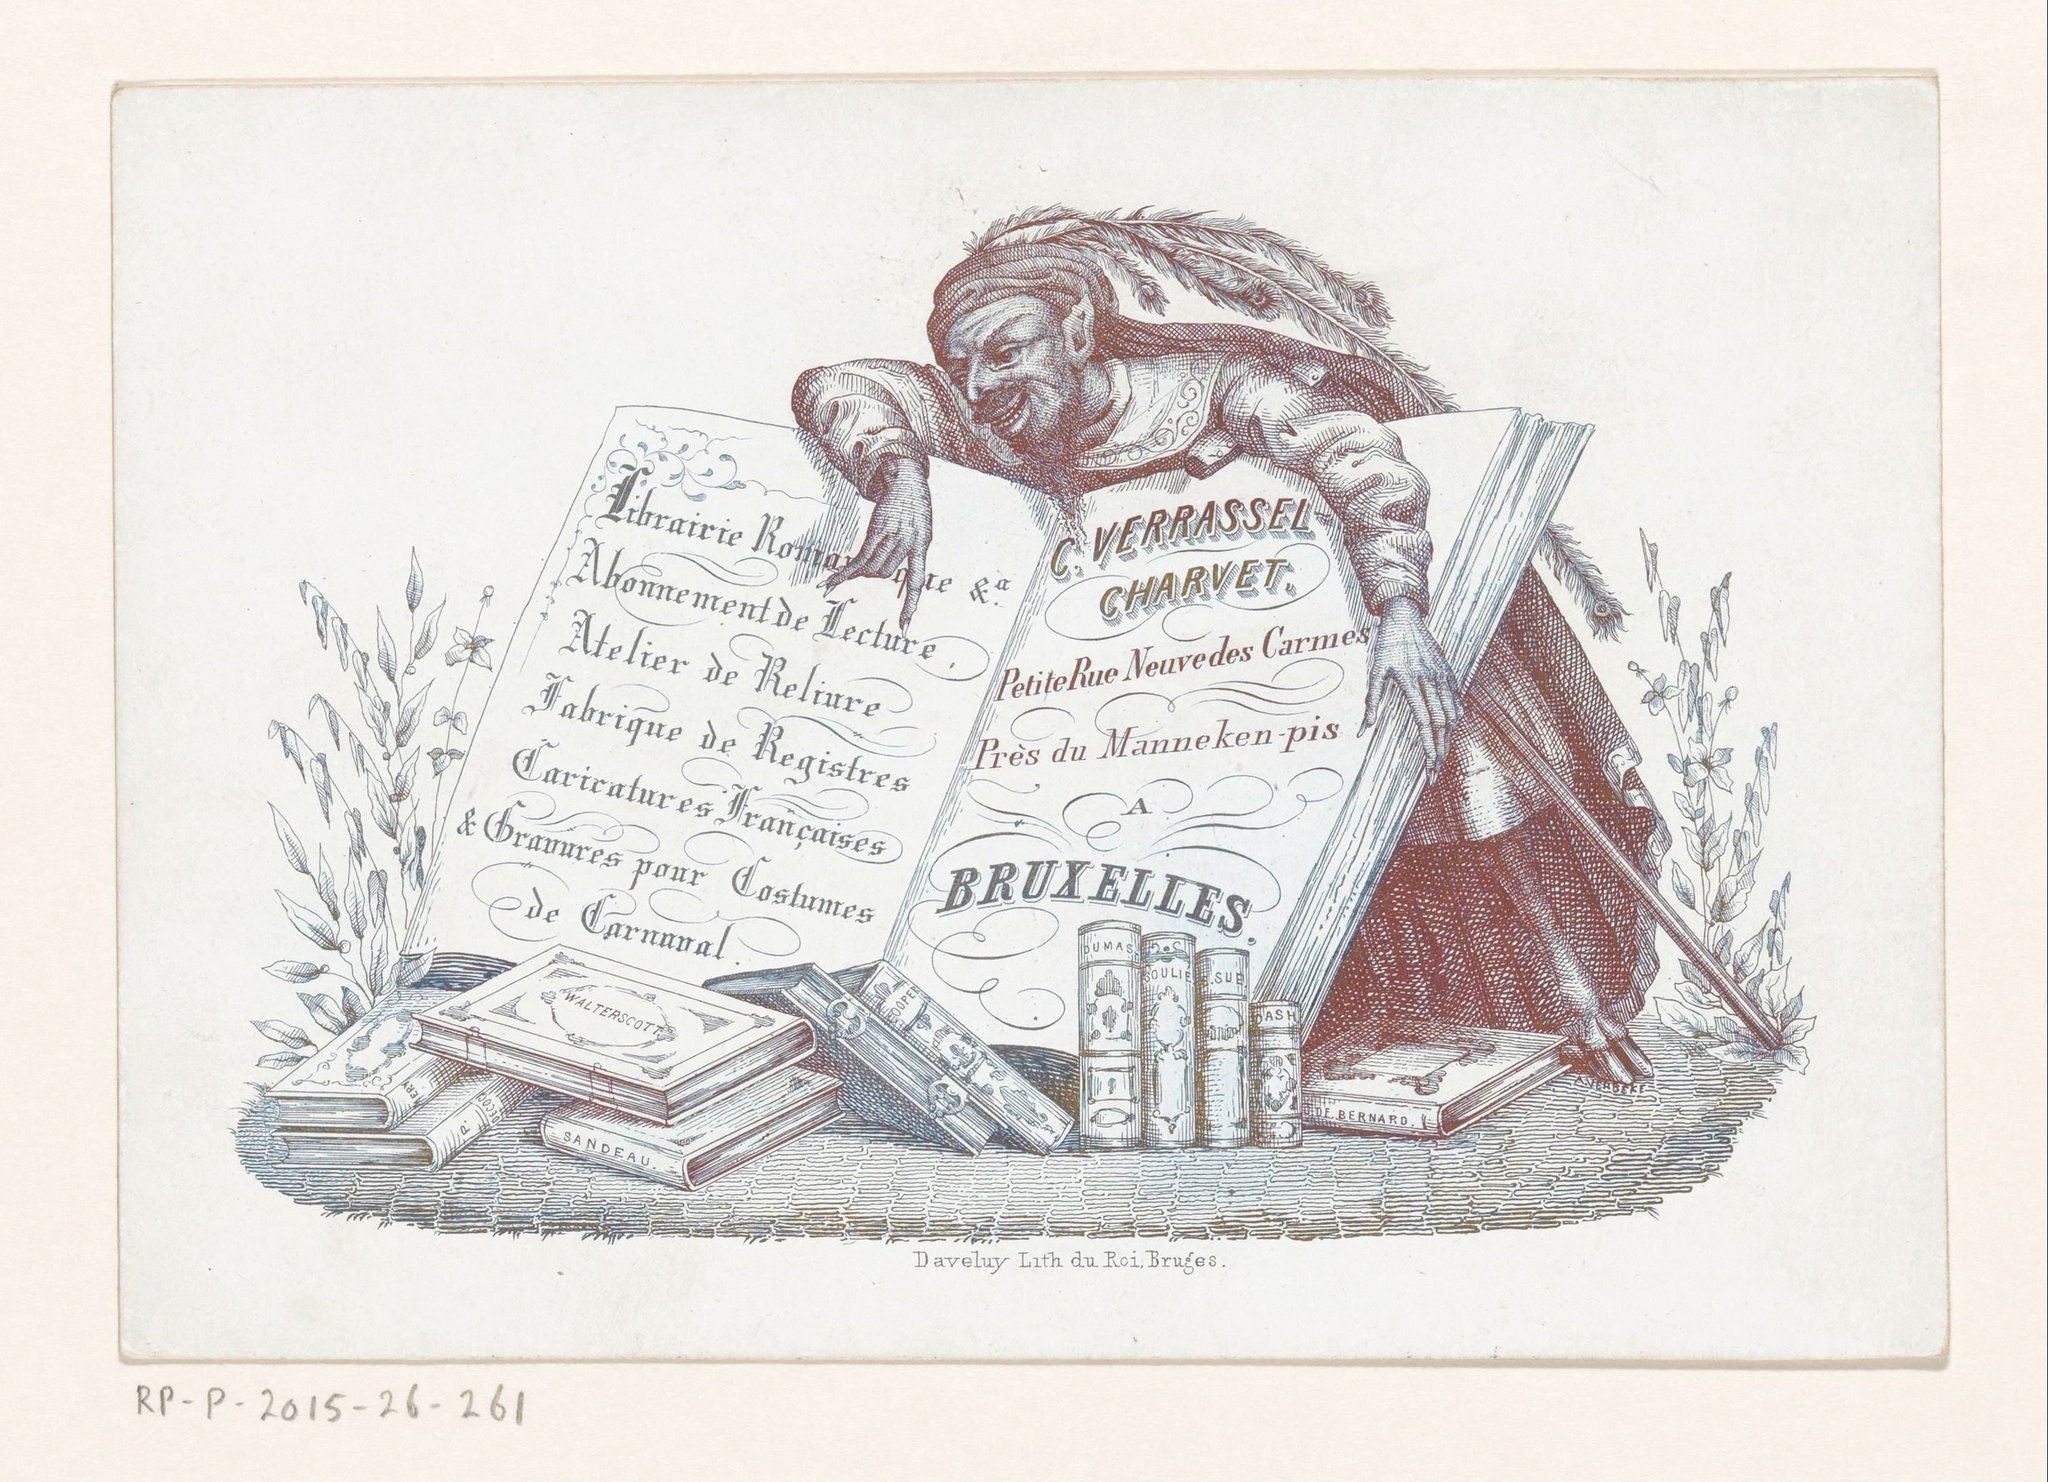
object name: visiting card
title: Visitekaartje van boekhandel C. Verrassel-Charvet te Brussel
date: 1842-1894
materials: porcelainized cardboard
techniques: lithograph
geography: bruges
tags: book, satyr(s) (in general), book-shop, bookseller, brussels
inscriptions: collector's mark: Lugt 4780, collector's mark: Lugt 2228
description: Een opengeslagen boek, omhooggehouden door een satyr met een baret met pauwenveren en een stok. Op de grond liggen verschillende boeken, door onder anderen Walter Scott, Dumas en Sandeau. Volgens de advertentie kunnen klanten bij de boekhandel terecht voor romans, abonnementen, het laten inbinden van boeken, kasboeken, karikatuurprenten en prenten voor carnavalskostuums.